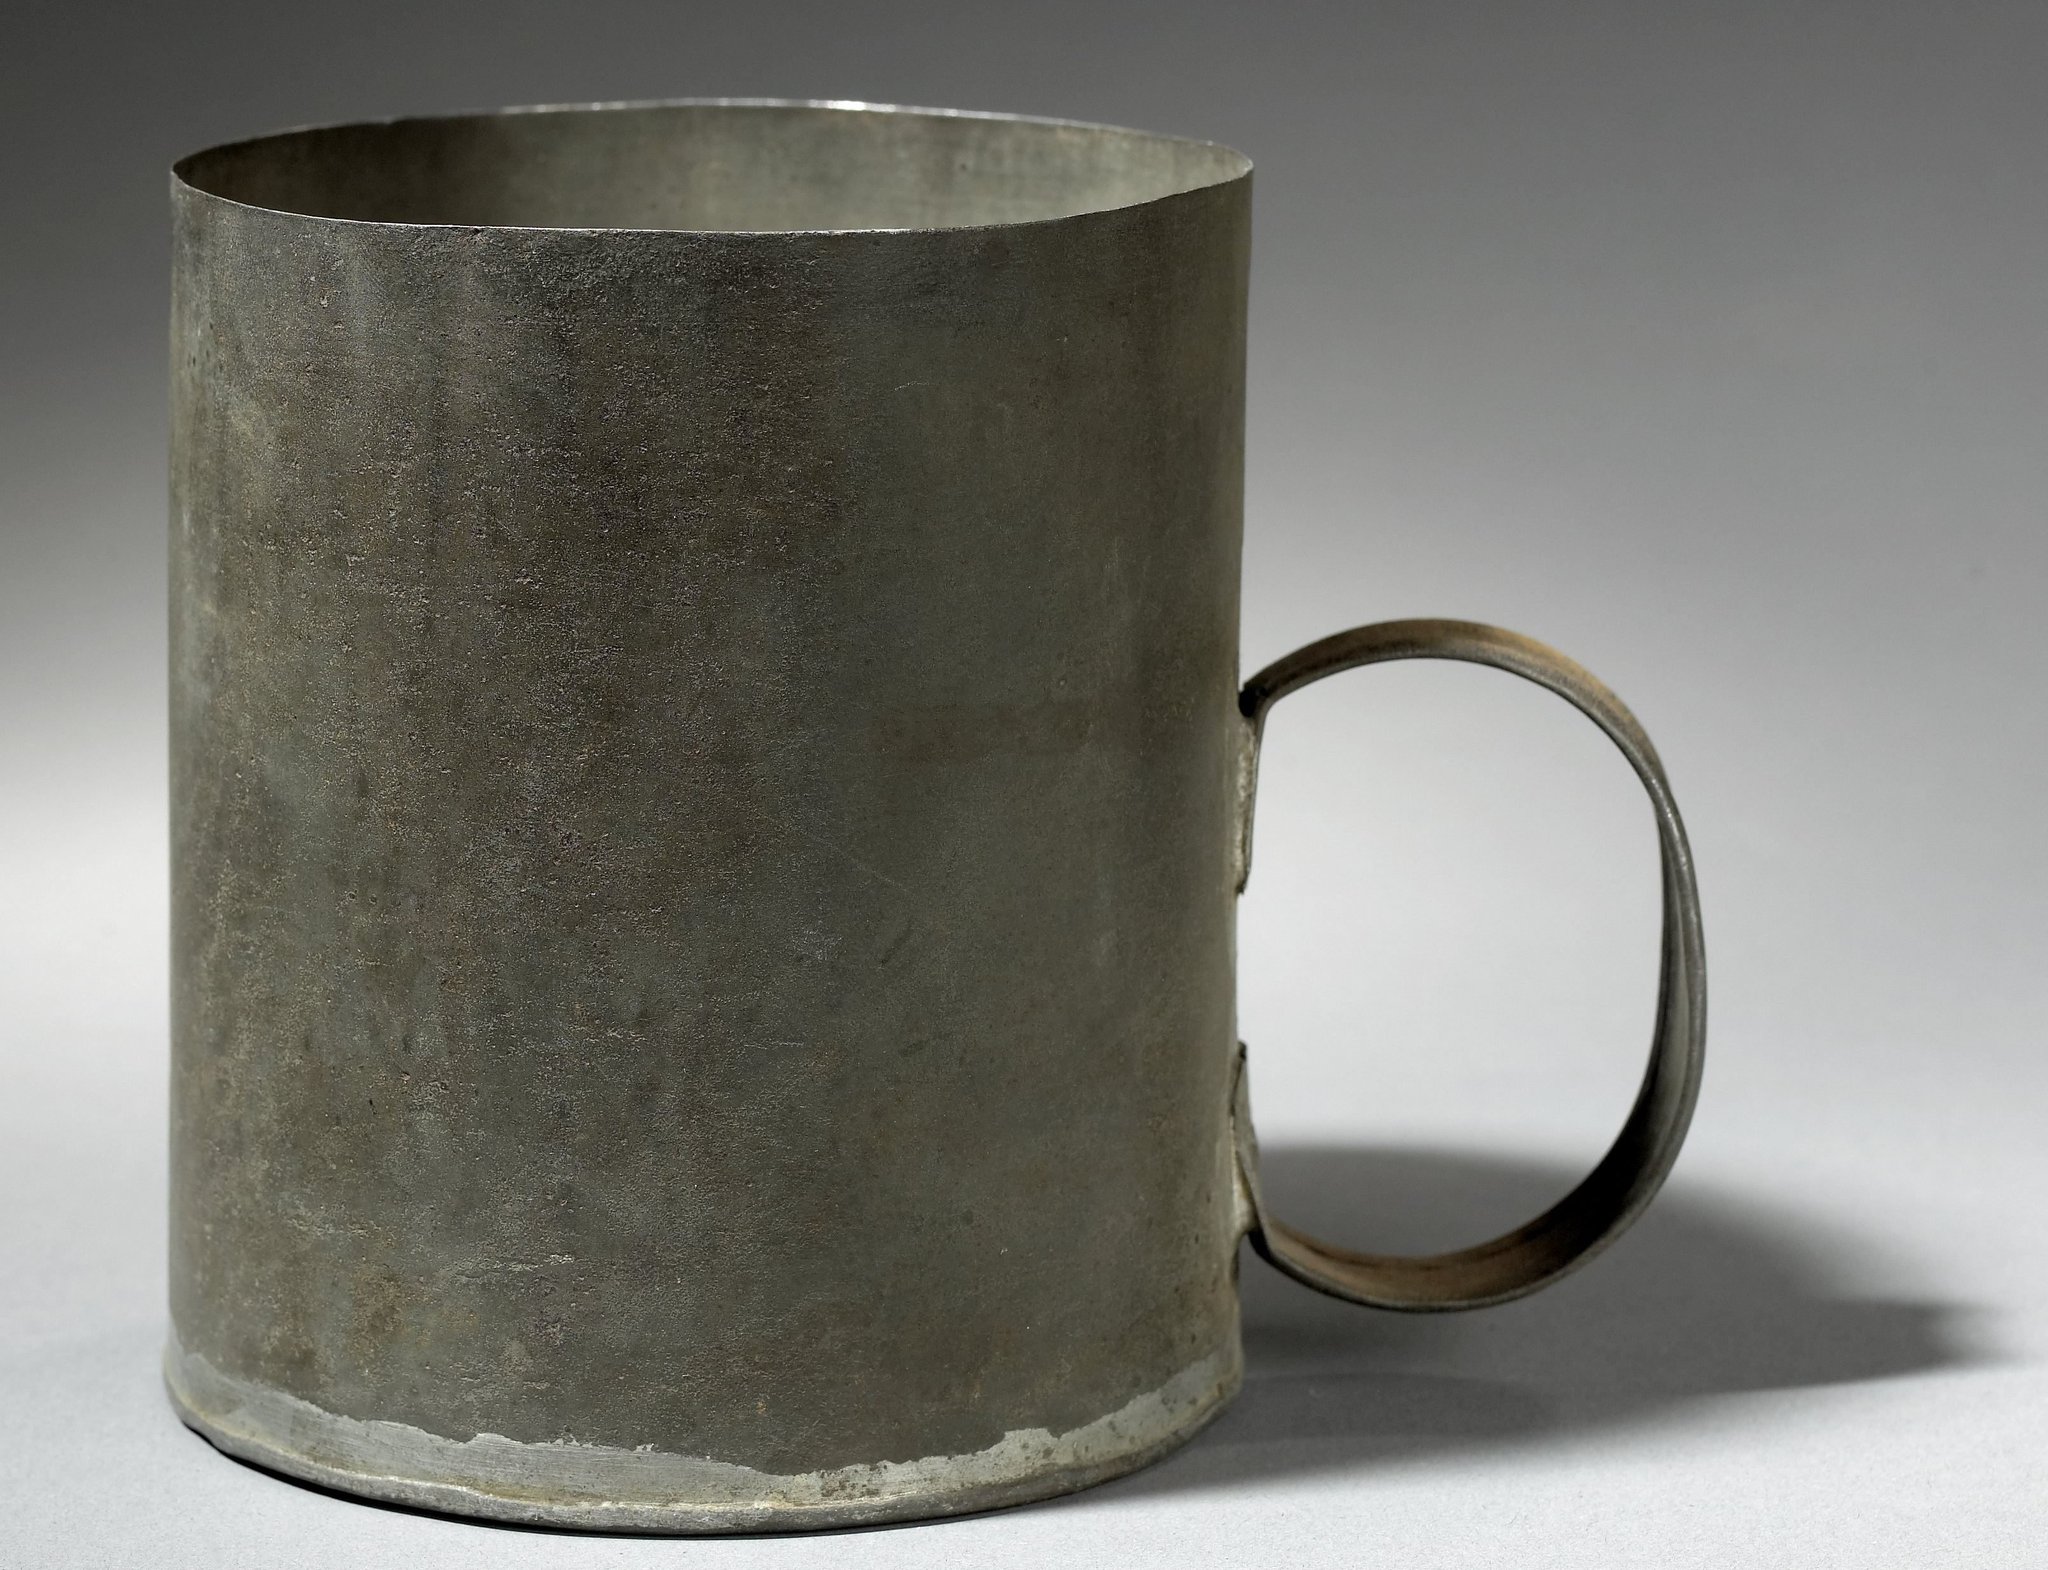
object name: inhoudsmaat natte waren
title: Maat van ca. 1 1/4 liter met handvat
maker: Anonymous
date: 1810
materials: metal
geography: amsterdam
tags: amsterdam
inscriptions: : ‘U’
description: Maat van Amsterdam van ca. 1 1/4 liter met handvat, gemerkt.